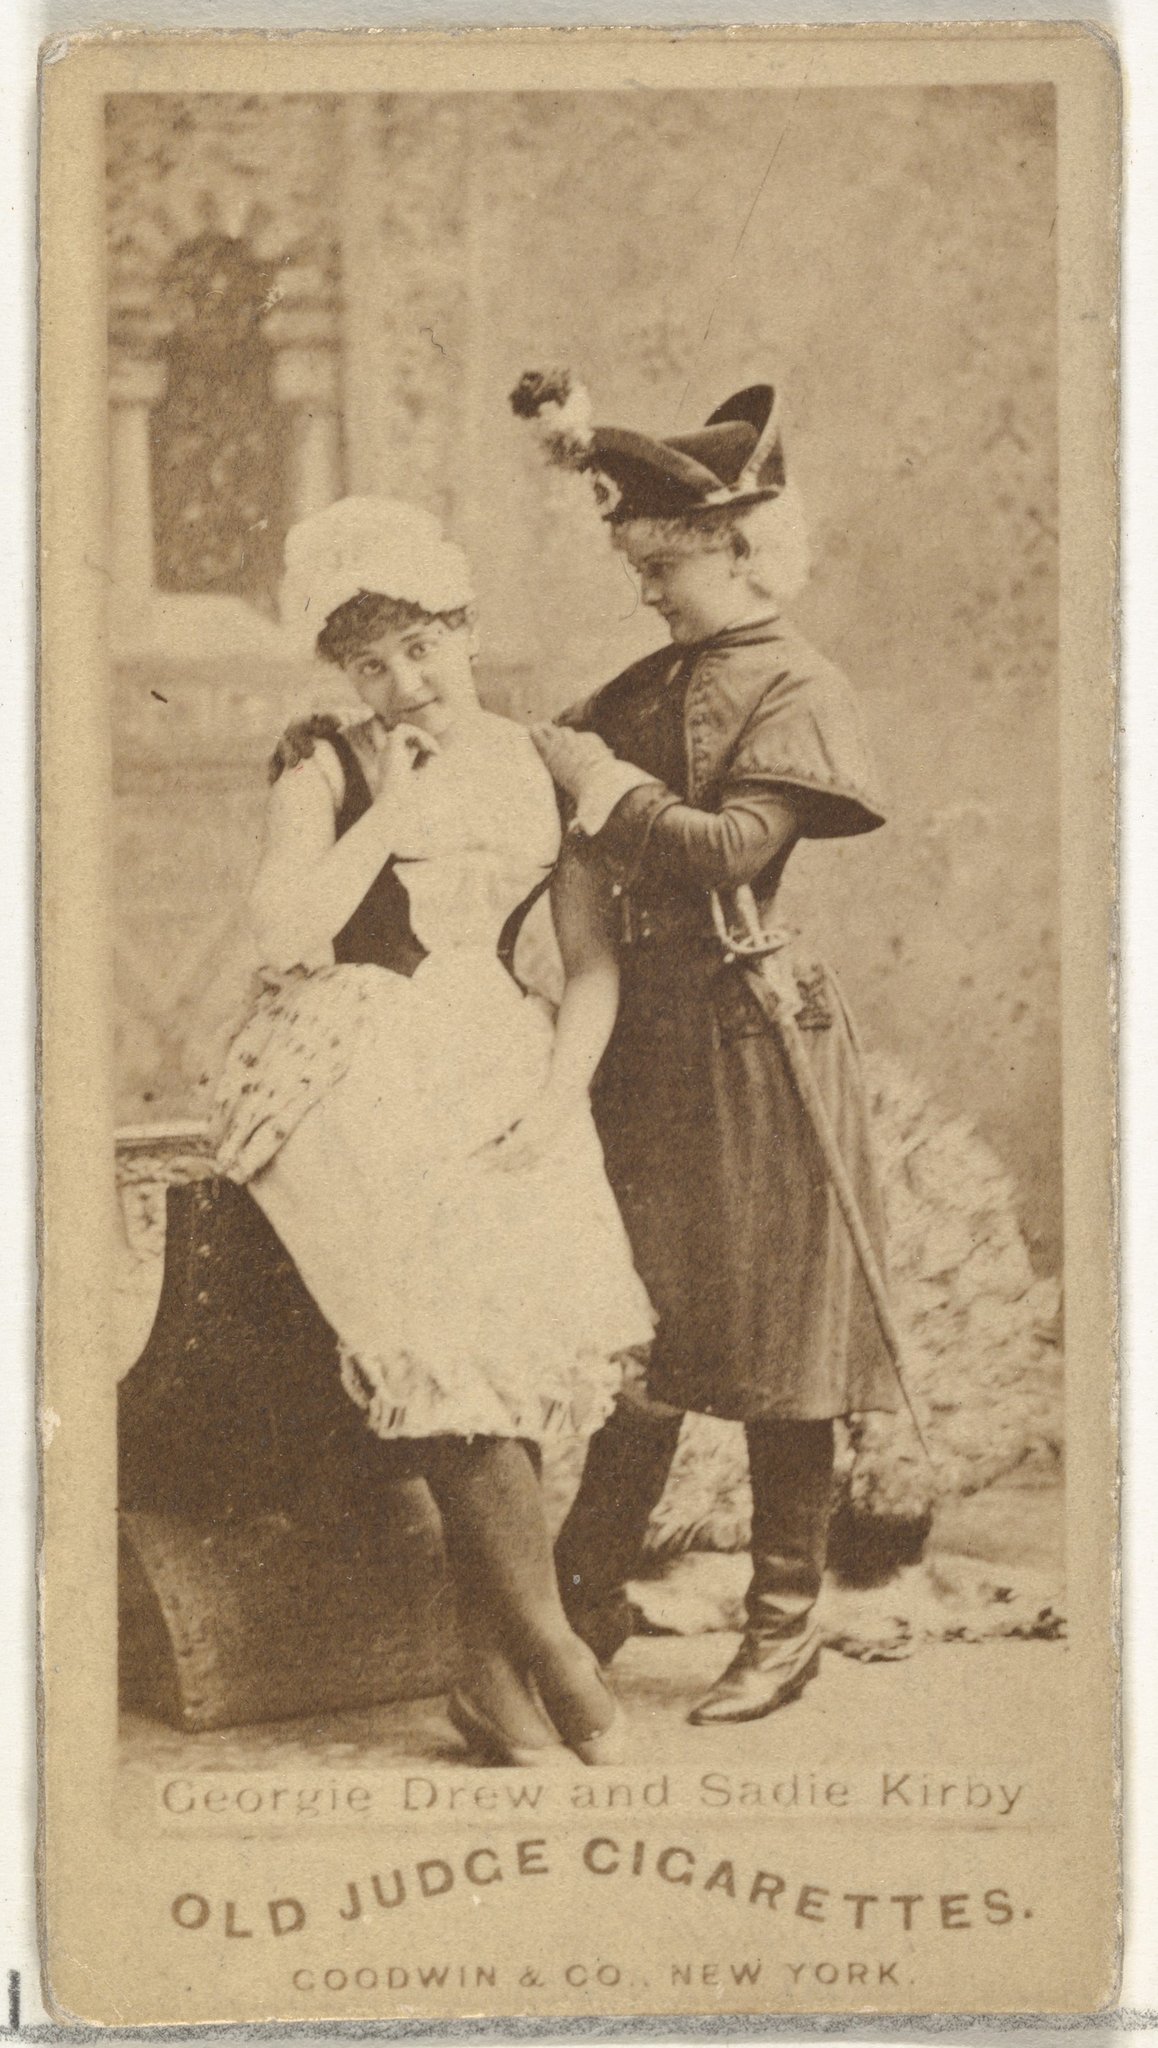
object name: photograph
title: Georgie Drew and Sadie Kirby, from the Actors and Actresses series (N171) for Old Judge Cigarettes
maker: goodwin & company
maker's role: publisher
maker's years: 1850-1950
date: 1886-1890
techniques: albumen silver print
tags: portraits,women,actresses